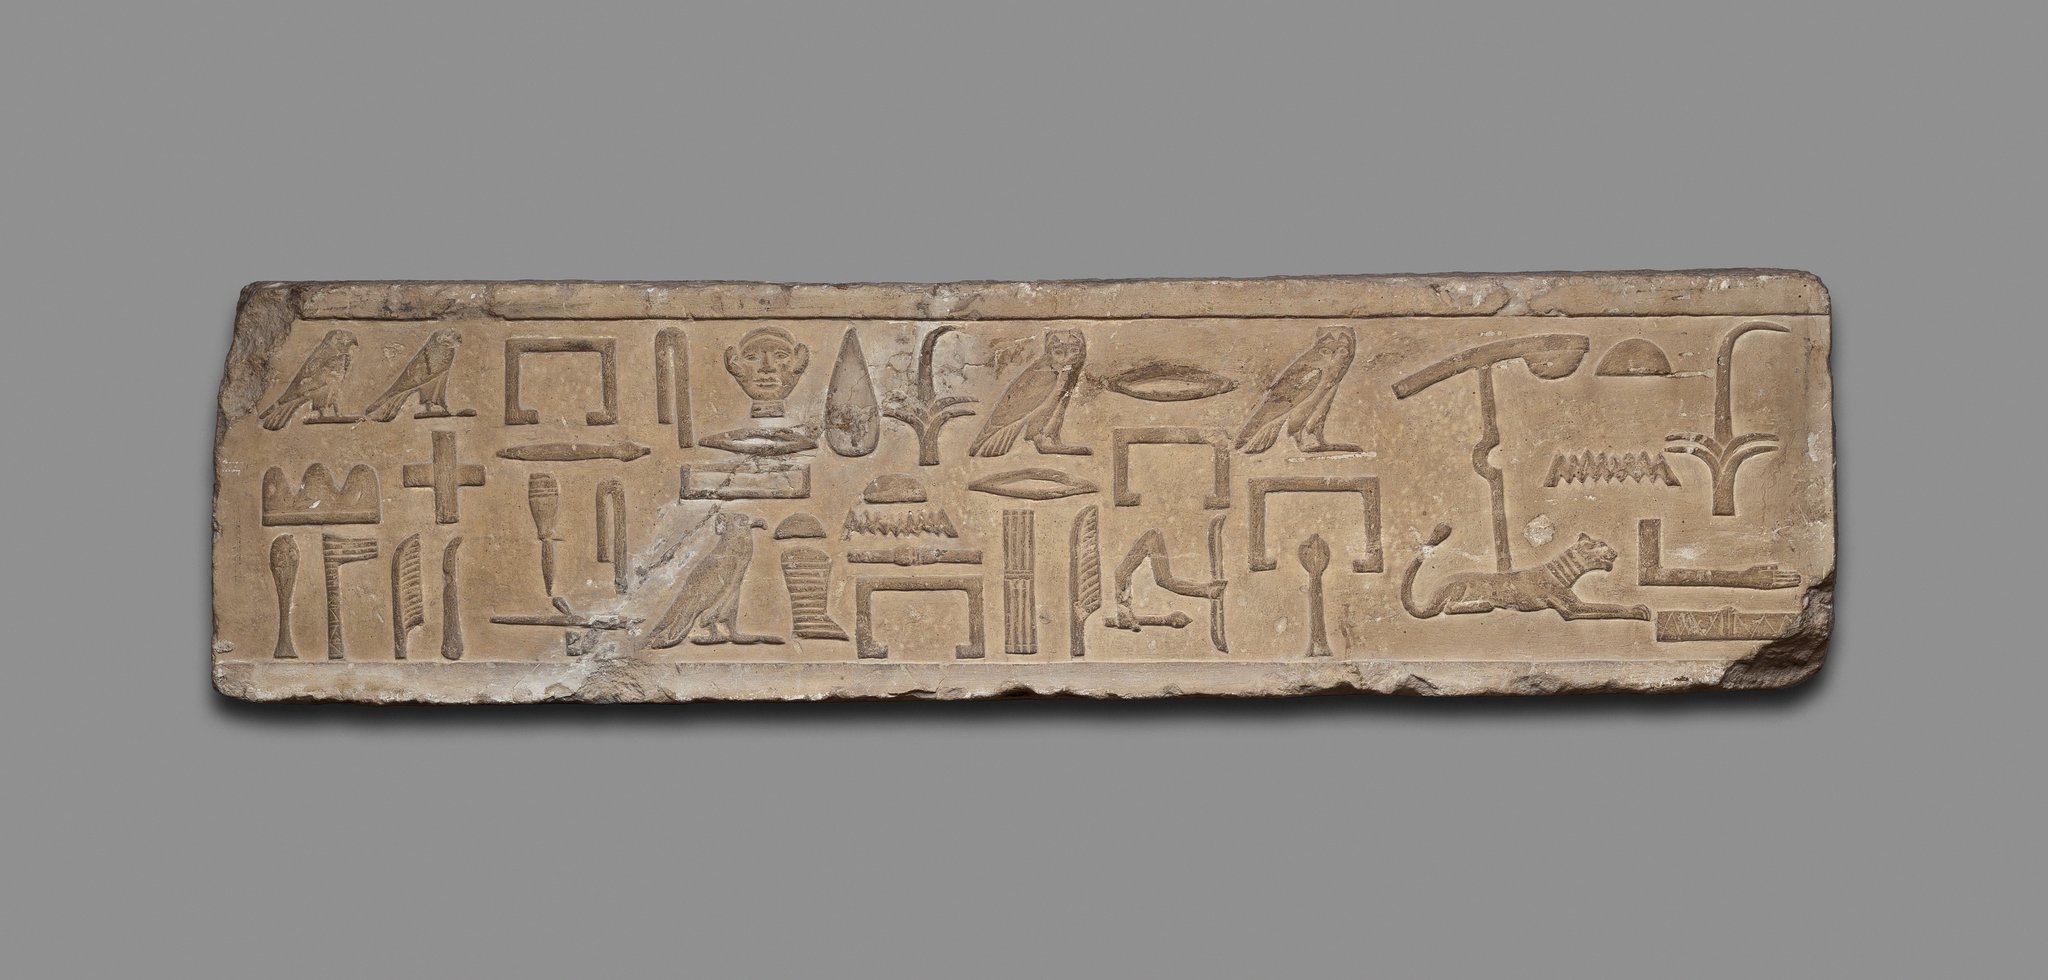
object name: false door, lintel block, mery's mastaba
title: Lintel block from the false door of Mery's chapel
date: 2575-2520 BCE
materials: limestone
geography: egypt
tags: hieroglyphs